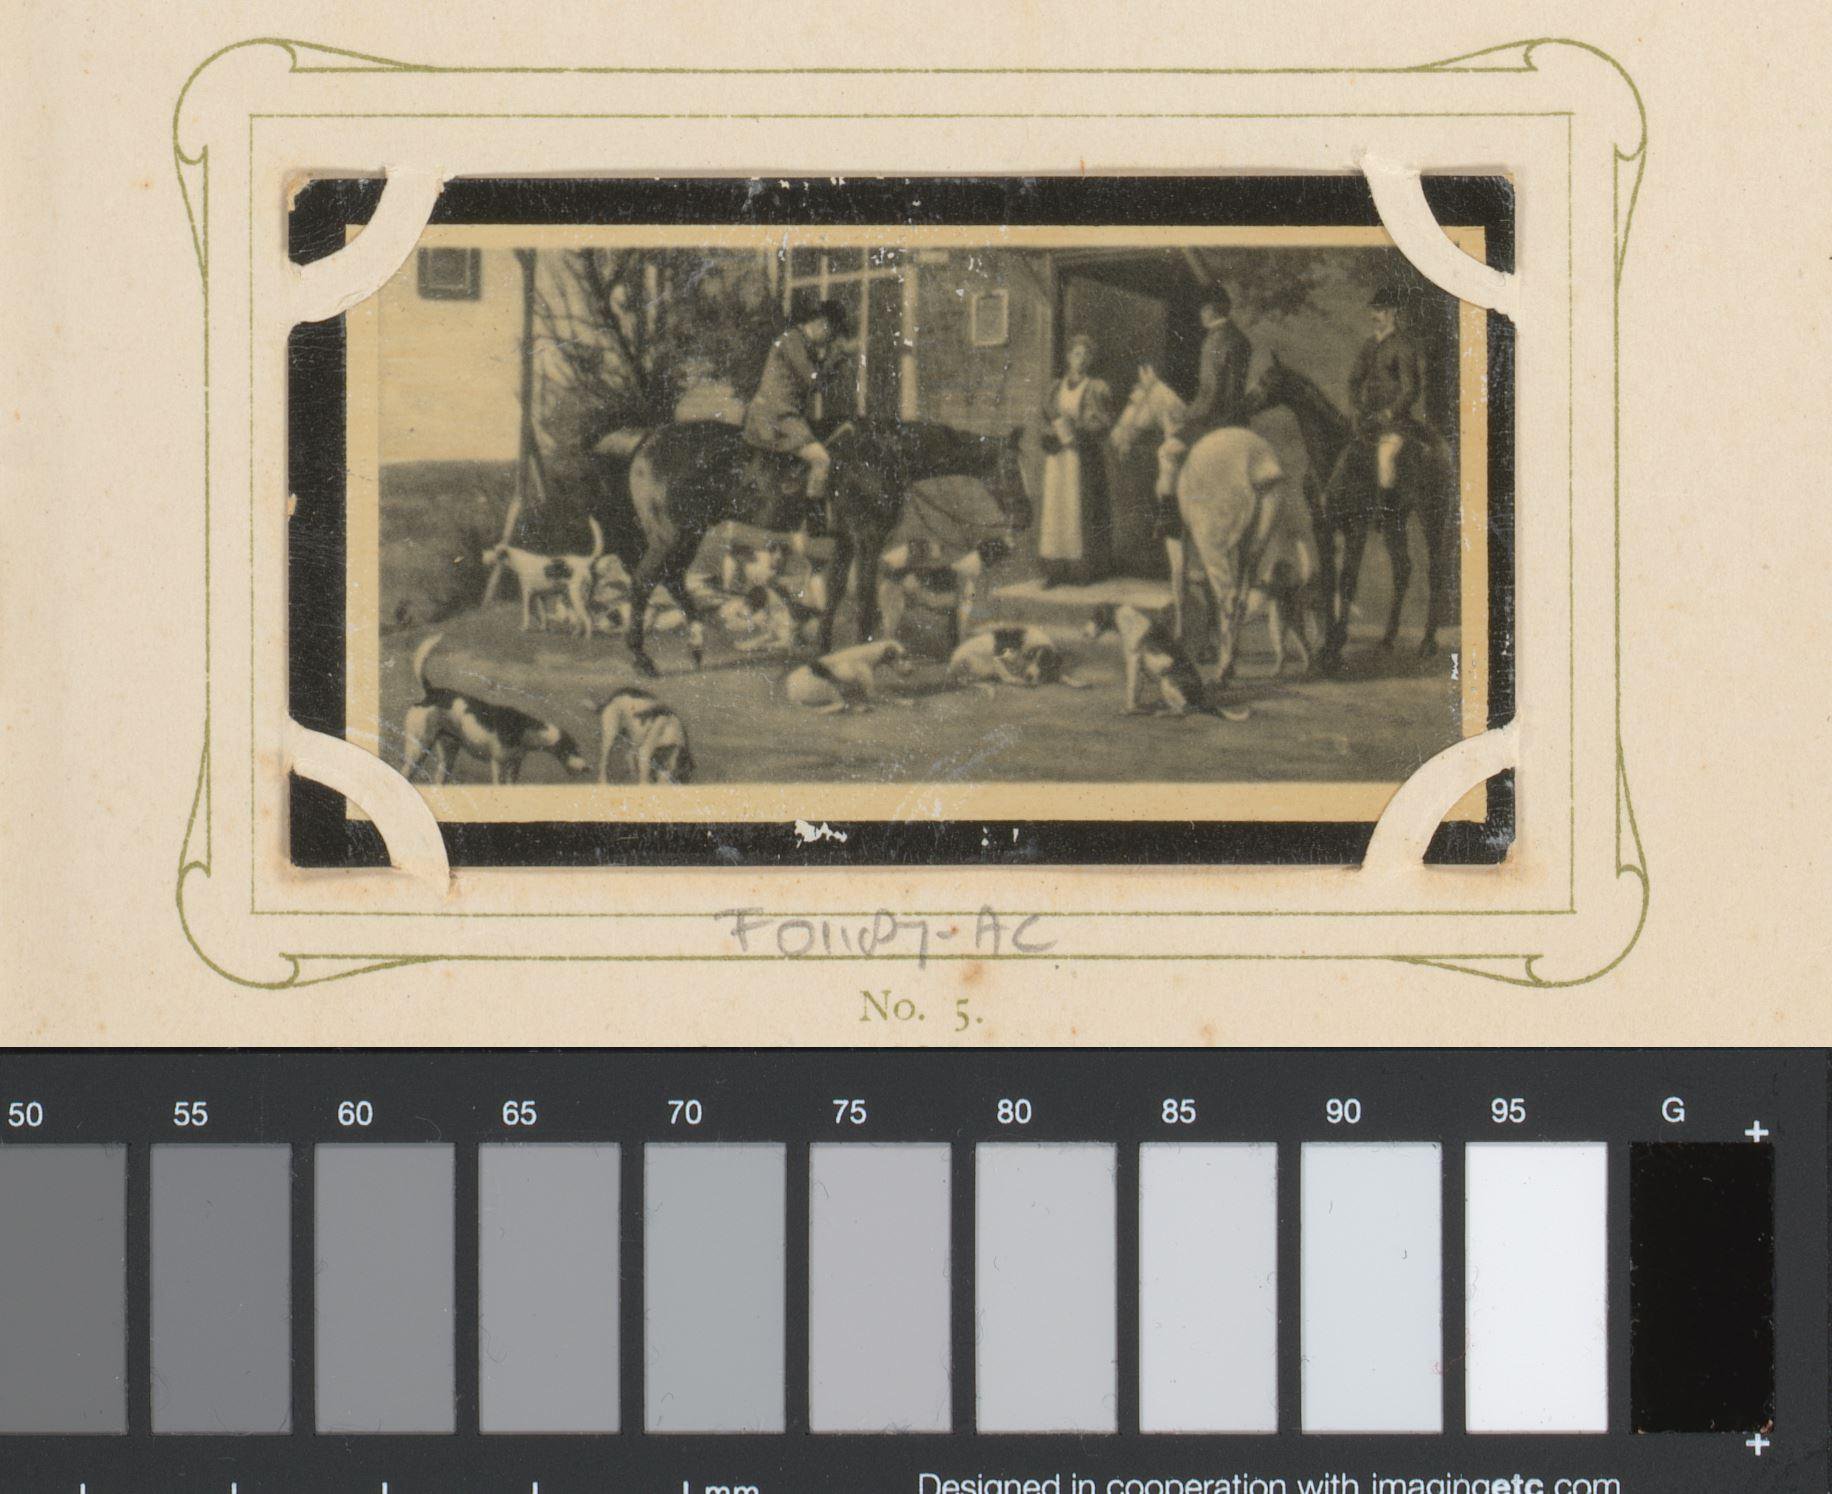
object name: photomechanical print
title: Reproductie van een tekening van een groep paarden met ruiters en honden die even rust nemen tijdens de jacht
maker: Anonymous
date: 1905-1906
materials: paper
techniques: photograph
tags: riding a horse, ass, or mule; rider, horseman, hunting, chase, hunting dogs, resting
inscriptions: inscription: ‘No. 5./ 'n Oogenblik rusten.’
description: Deze prent maakt deel uit van een album.